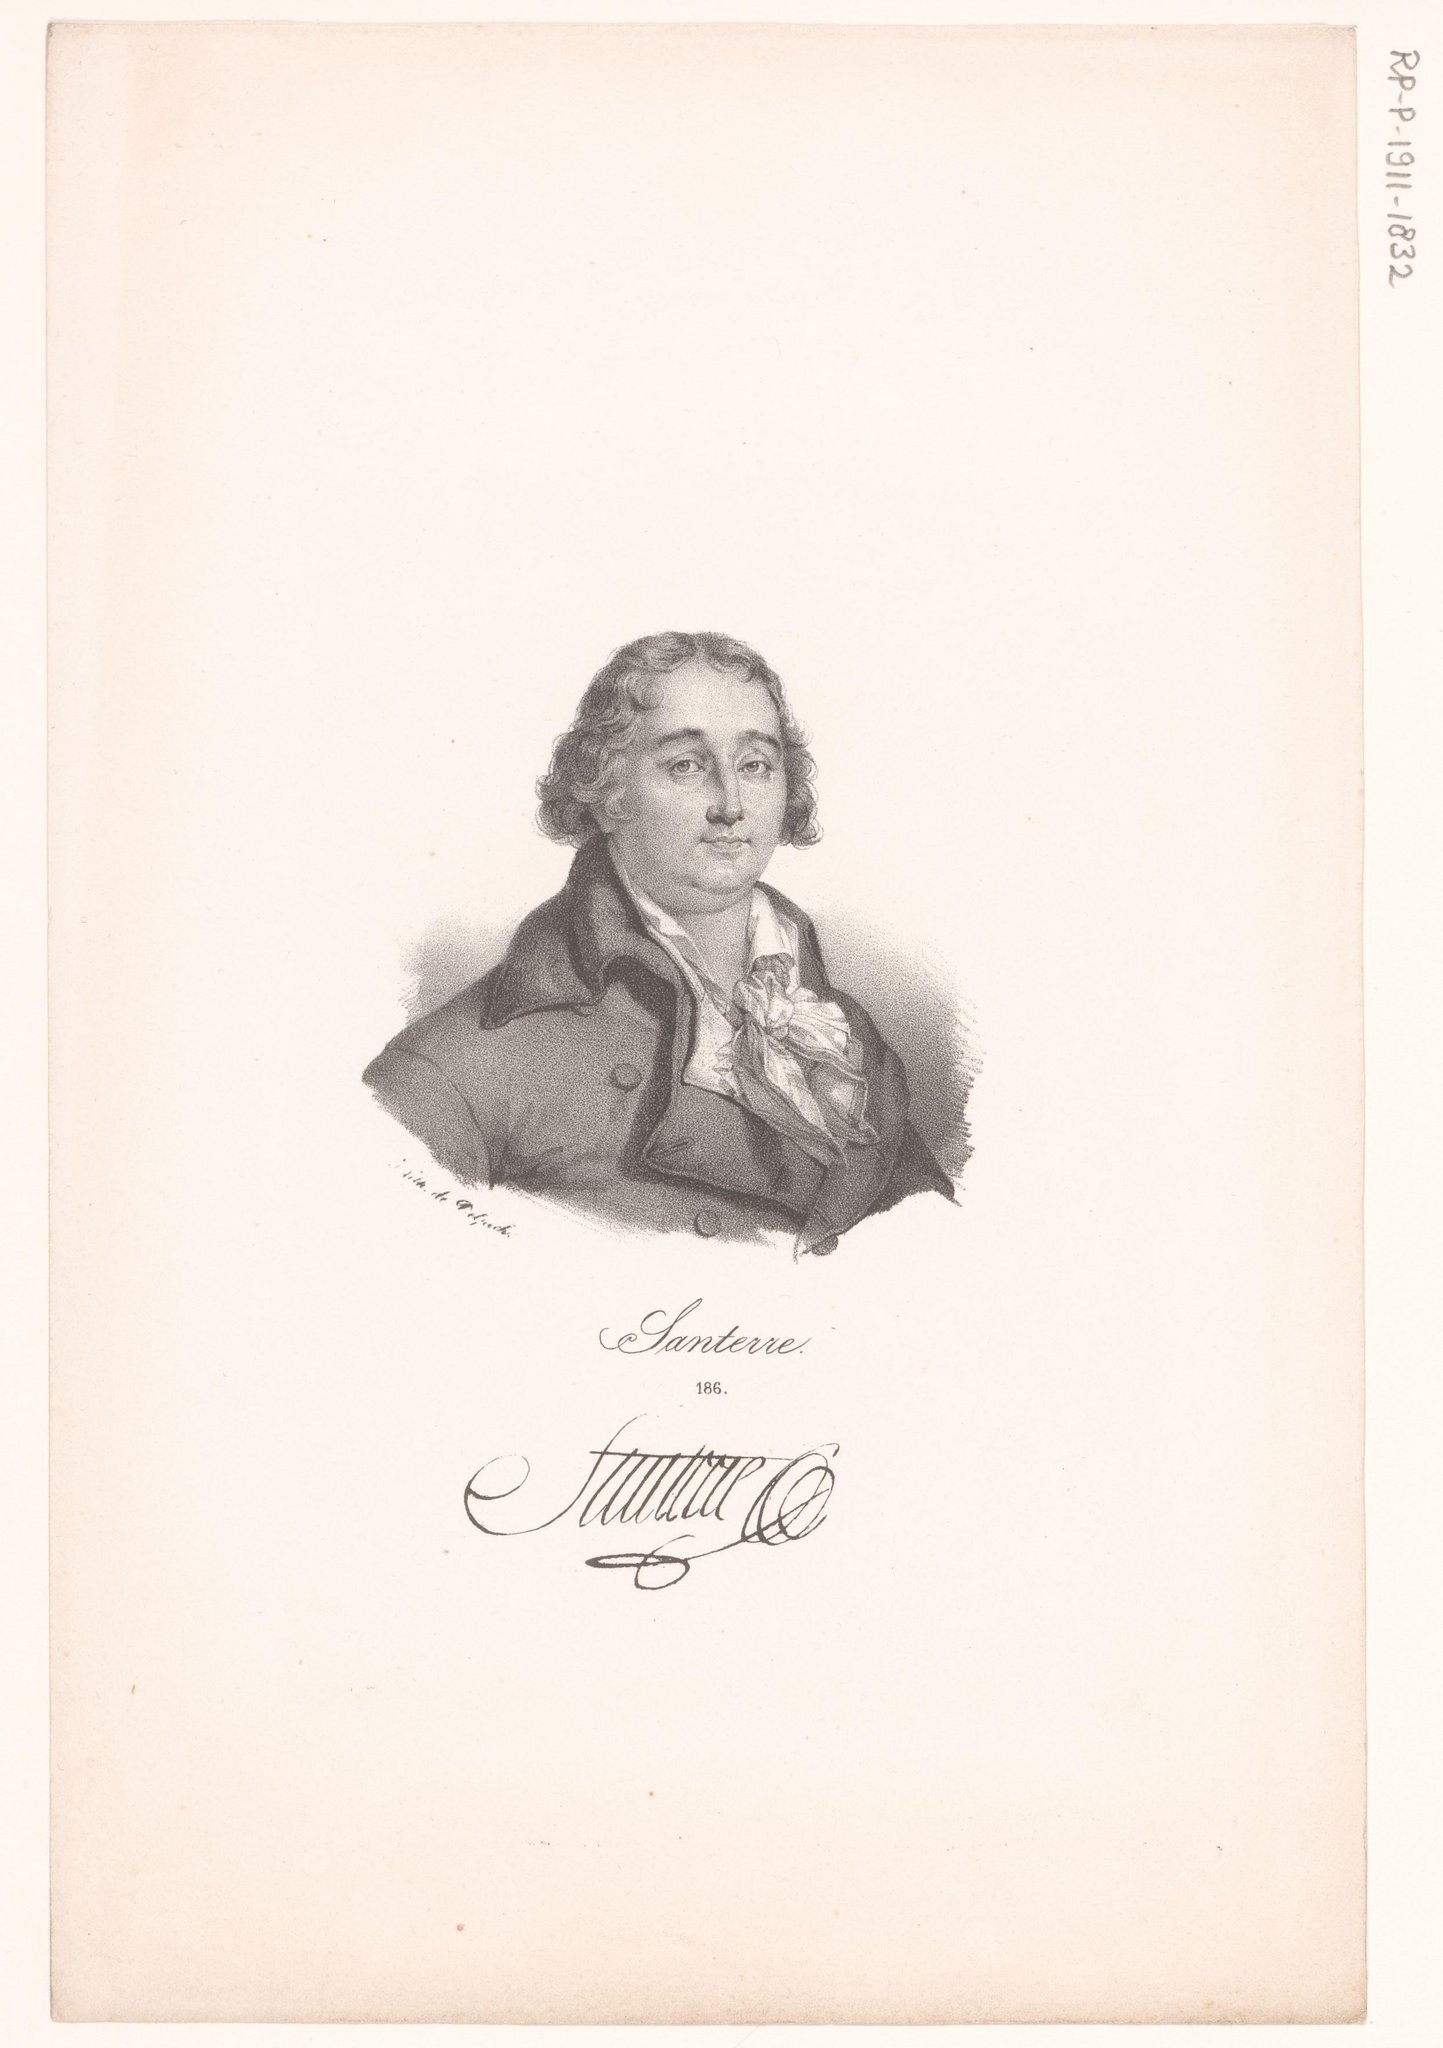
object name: print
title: Portret van Antoine Joseph Santerre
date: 1818-1842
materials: paper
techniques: lithograph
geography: paris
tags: historical persons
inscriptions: collector's mark: Lugt 2228a